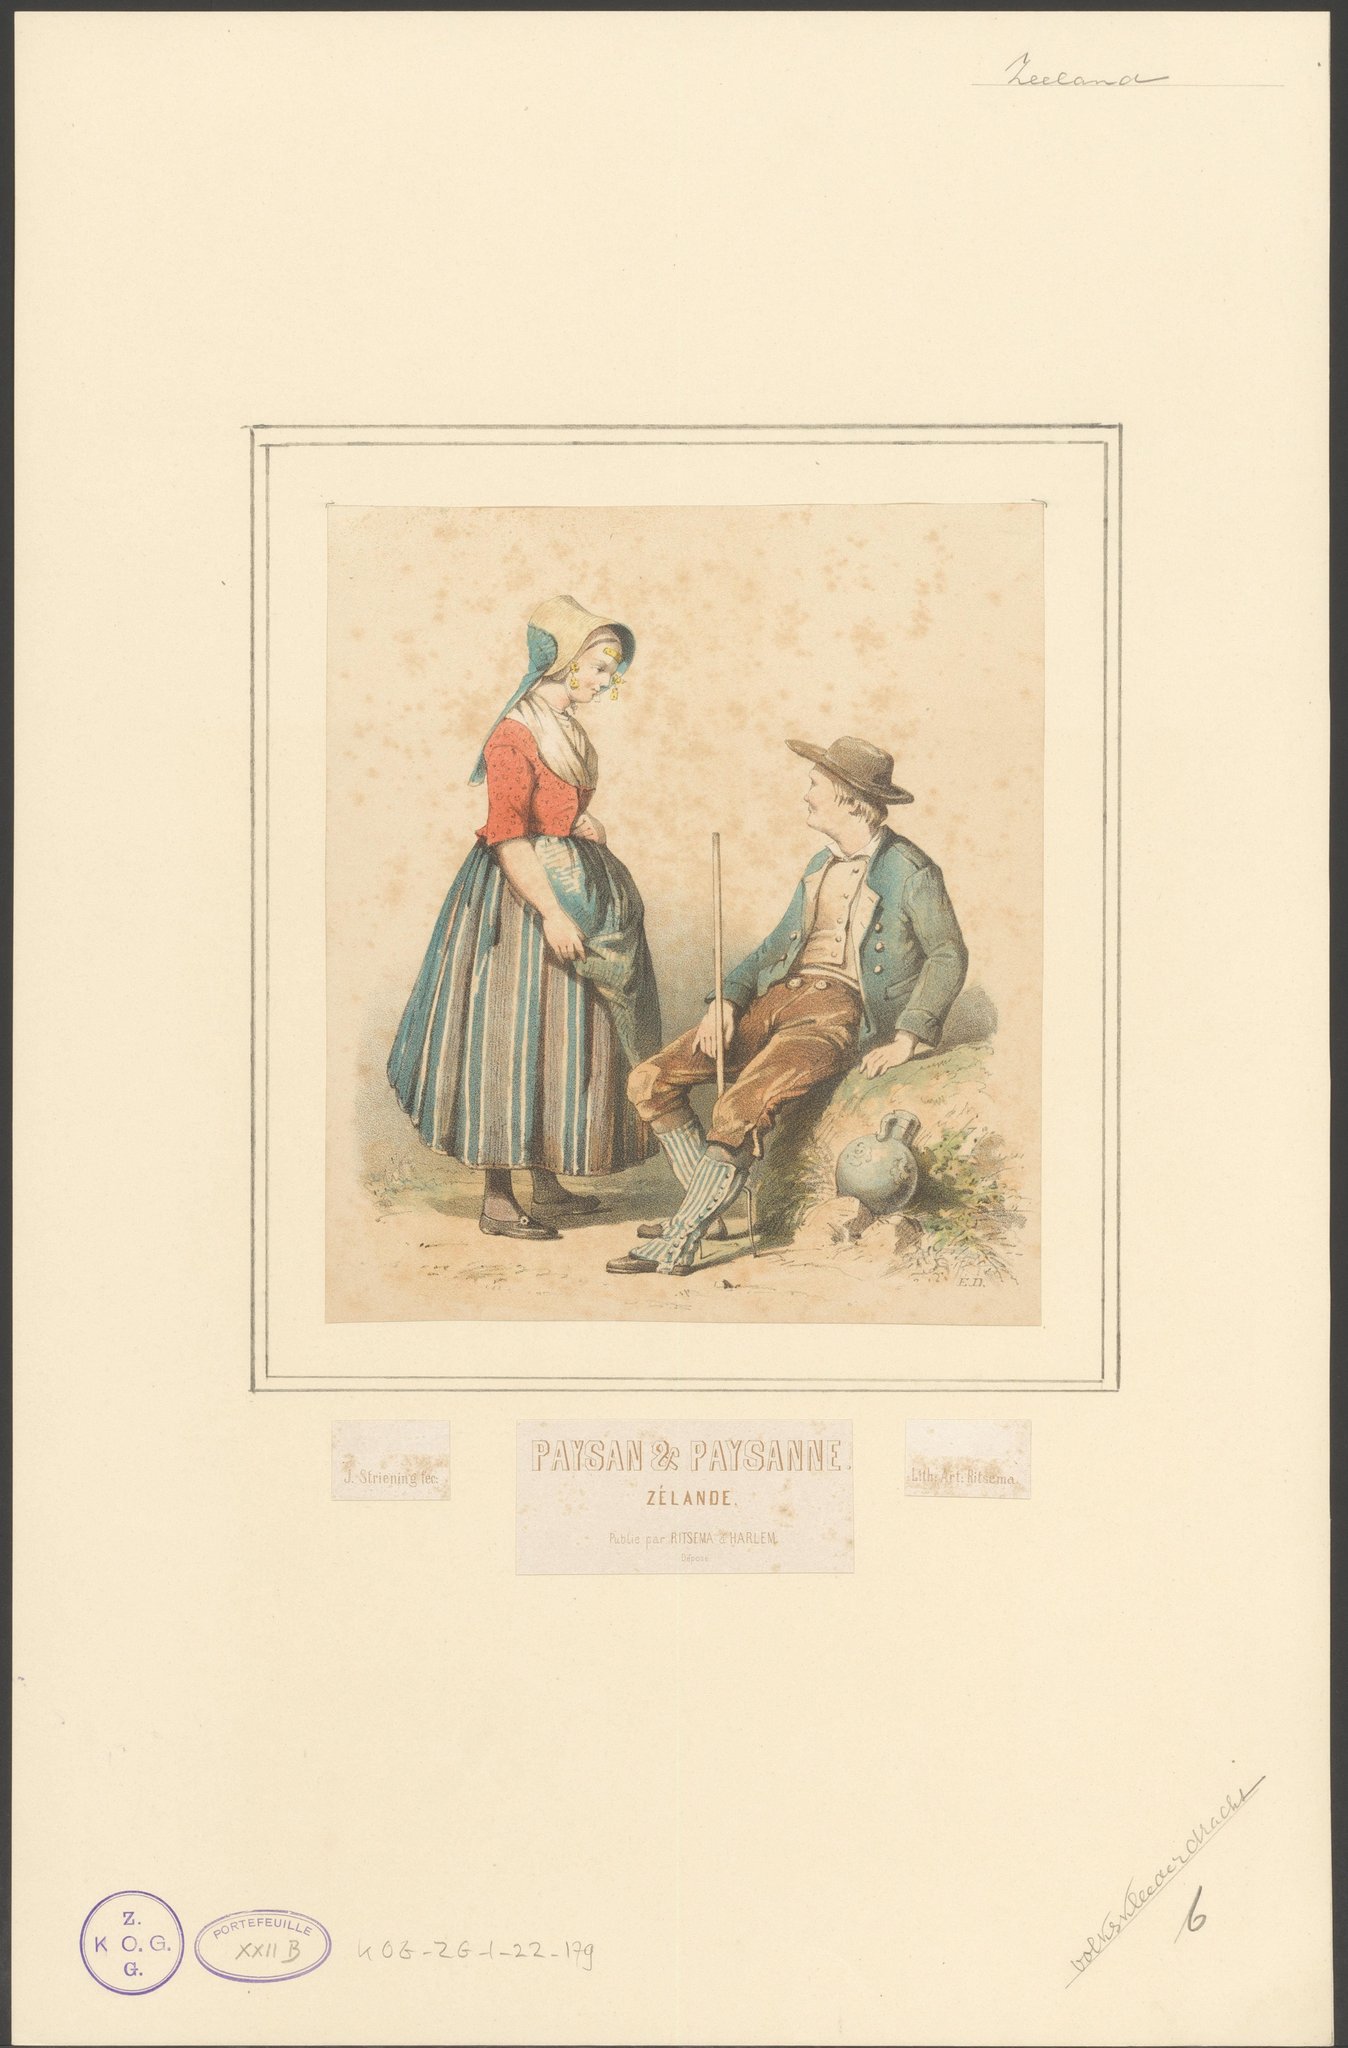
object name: print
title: Boer en boerin van Zeeland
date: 1858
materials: paper, watercolor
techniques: hand coloring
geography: netherlands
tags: farmers, farmers - aa - female farmer, farmer's wife, clothes, costume (+ women's clothes), clothes, costume (+ men's clothes), folk costume, regional costume, zeeland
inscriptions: collector's mark: Lugt 1641, collector's mark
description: Boer en boerin van Zeeland. Samengesteld uit vier verknipte stukken van het originele blad. Onderwerpsrubrieken binnen de Atlas Zeden en Gewoonten: De Kleeding, Volkskleederdracht, Zeeland.